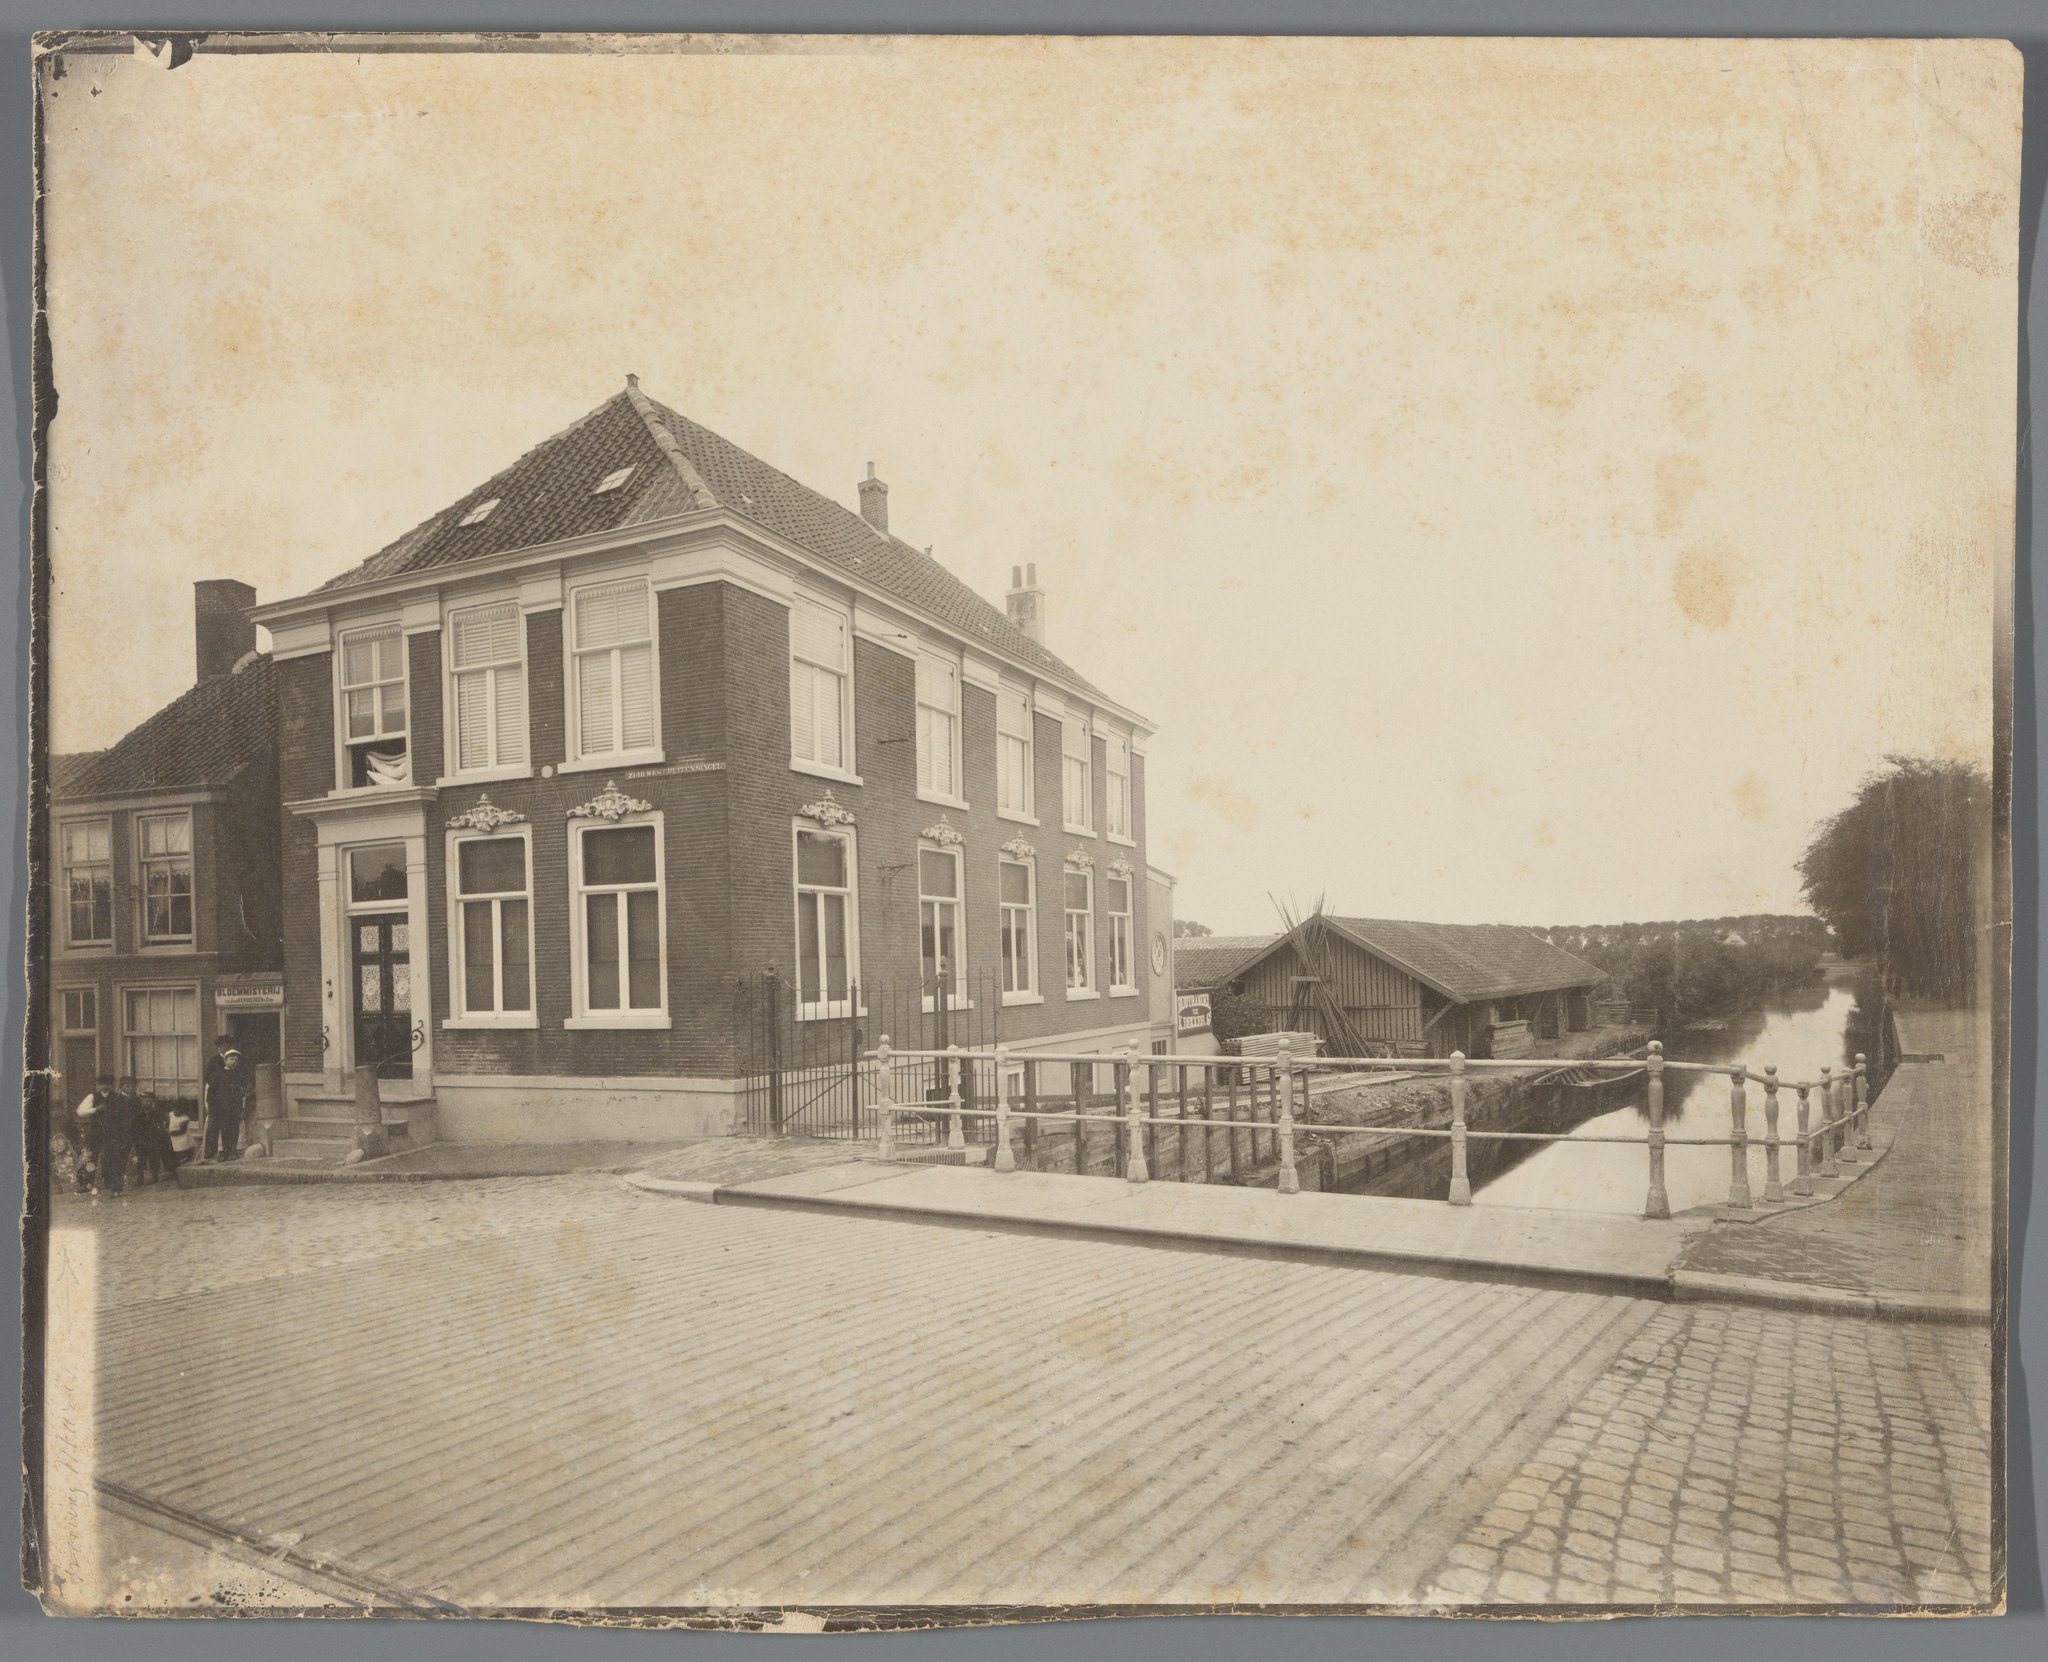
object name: photograph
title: Huizen van de familie (F.A.Th. ) Delprat en familie Maris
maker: theodore felix albert delprat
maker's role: politician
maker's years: 1851-1932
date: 1886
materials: paper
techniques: gelatin silver print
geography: the hague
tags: the hague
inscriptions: inscription: ‘Loosduinse Vaart’, inscription: ‘woning Maris’, inscription: ‘P. Haverkorn van Rijswijk Den Haag 12 c. breed foto zorgvuldig bewaren en retour aan eigenaar’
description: Het huis van de familie (F.A.Th. ) Delprat in Den Haag aan Noordwest Buitensingel, ernaast het huis van de familie Maris.